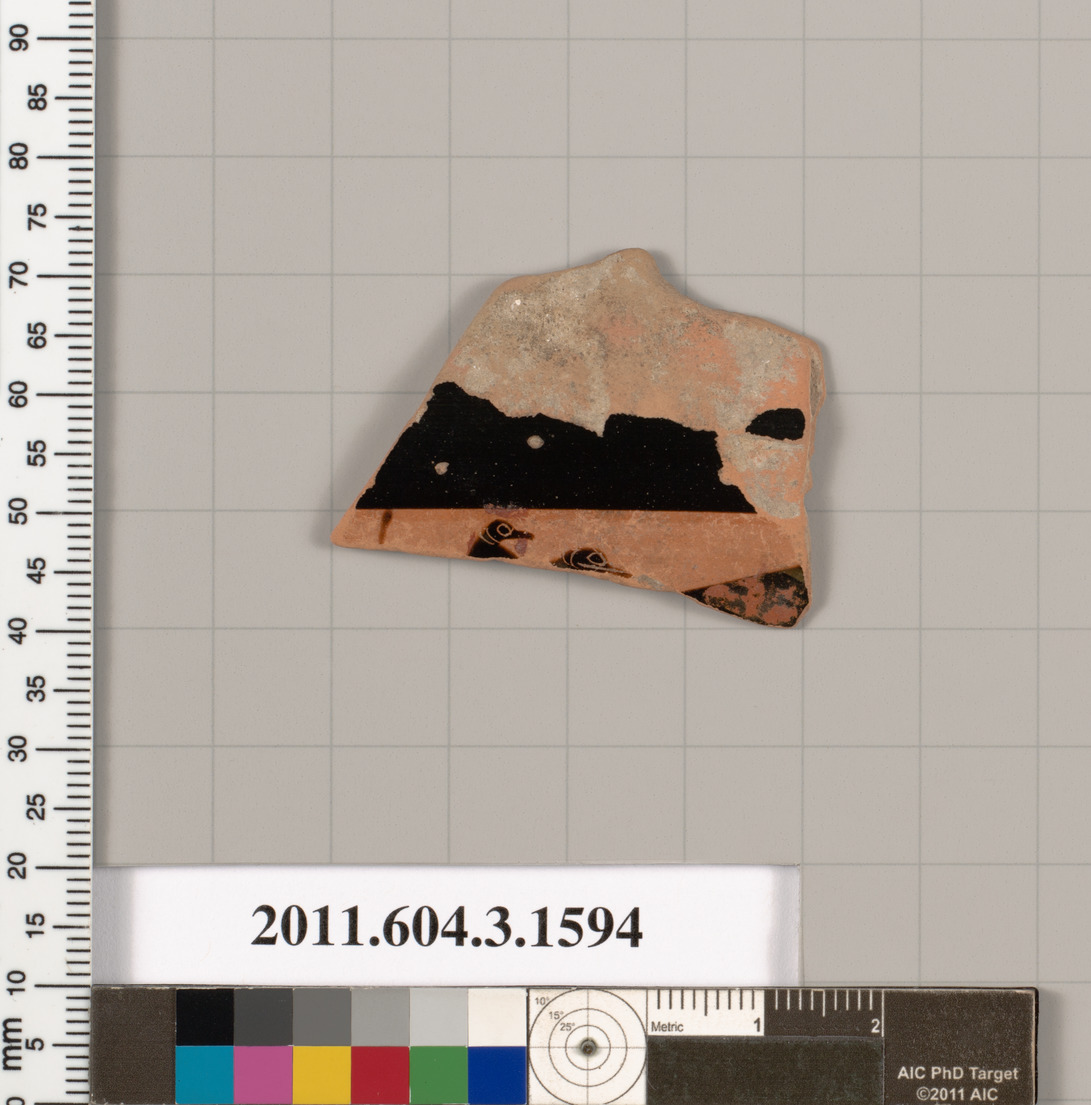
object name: kylix fragment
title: Terracotta fragment of a kylix: Band cup (drinking cup)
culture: greek, attic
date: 550-526 BCE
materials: terracotta